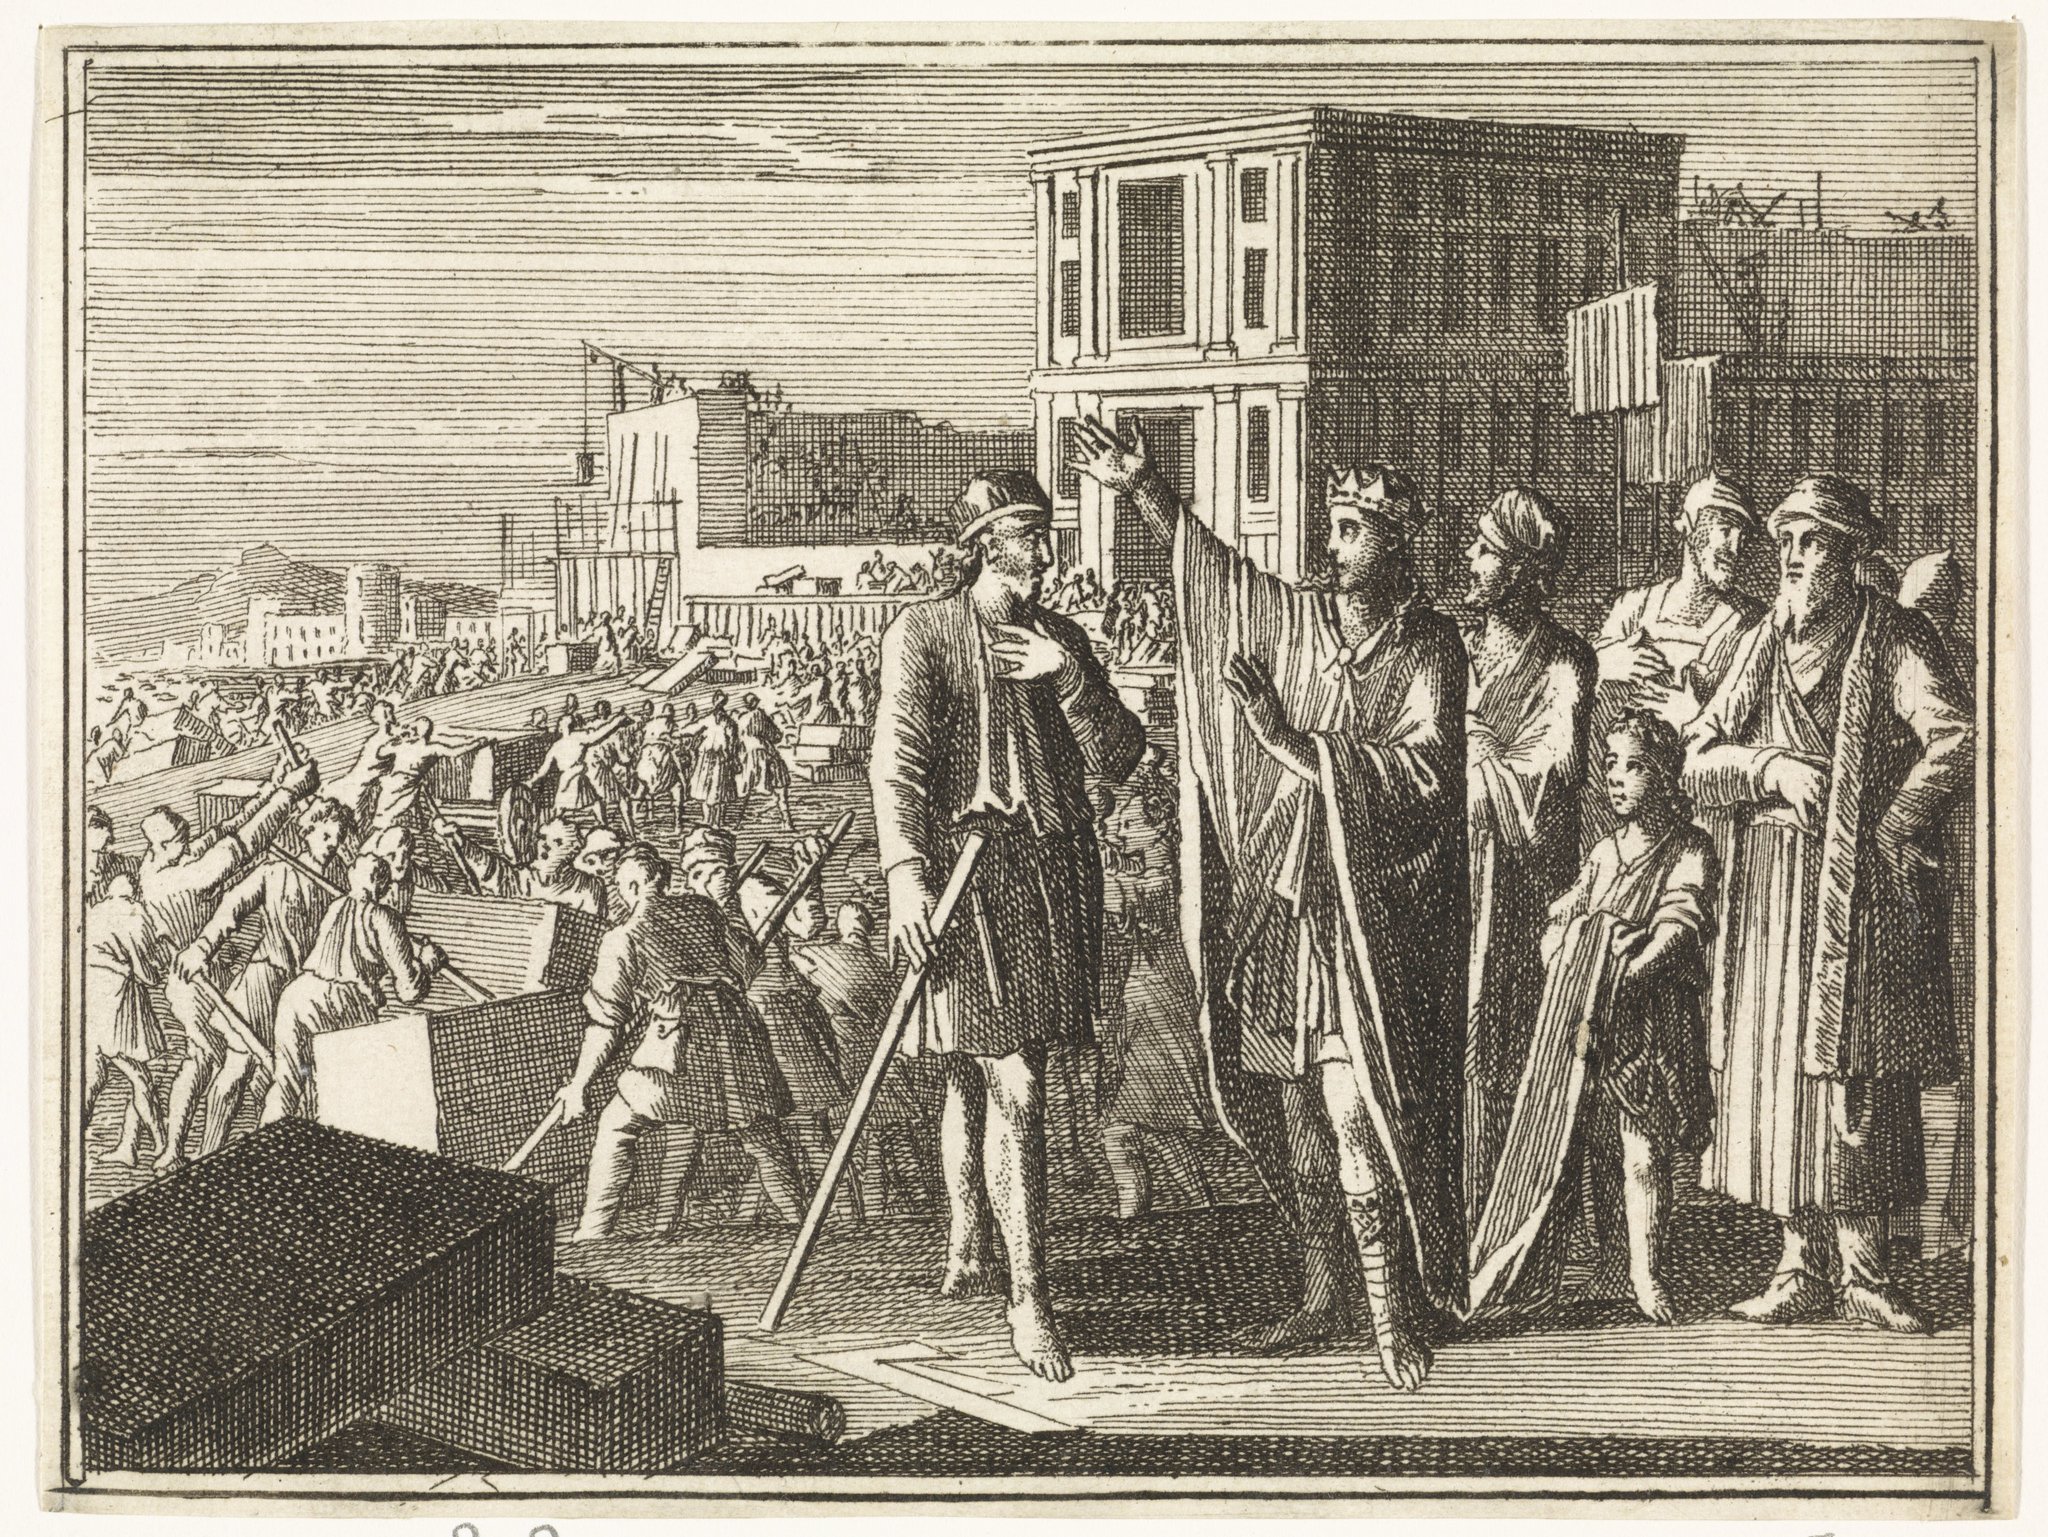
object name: print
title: Koning Salomo bouwt de tempel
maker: caspar luyken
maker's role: draughtsman, print maker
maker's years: 1672-1708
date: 1712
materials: paper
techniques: etching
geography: amsterdam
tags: the building of the temple of solomon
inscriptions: number: ‘124’, collector's mark: Lugt 2228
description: Illustratie uit: Luyken, Jan. De schriftuurlyke geschiedenissen en gelykenissen van het Oude en Nieuwe Verbond, 2 delen. Amsterdam: Wed. Pieter Arentsz II en Cornelis van der Sys, 1712, dl. I.